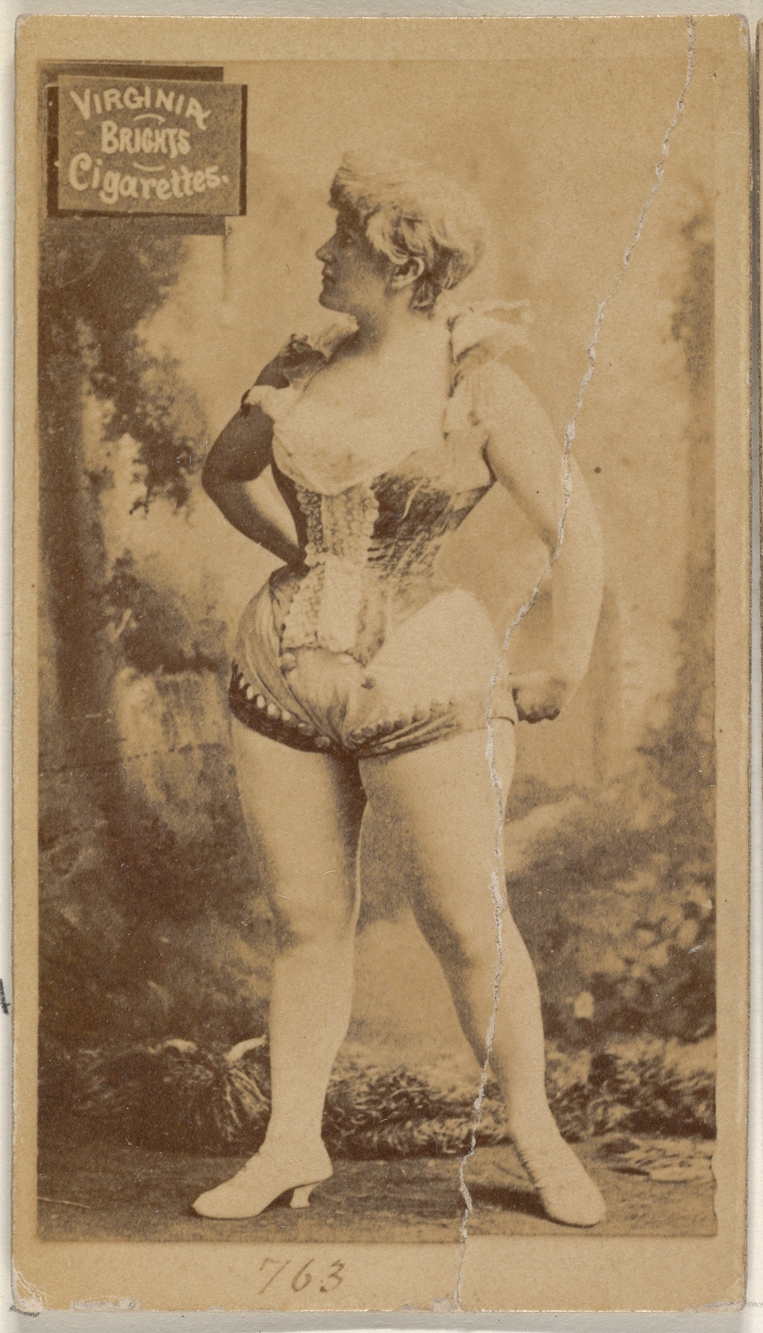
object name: photograph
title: Card 763, from the Actors and Actresses series (N45, Type 2) for Virginia Brights Cigarettes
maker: allen & ginter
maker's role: publisher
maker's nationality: american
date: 1888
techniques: albumen silver print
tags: portraits,women,actresses